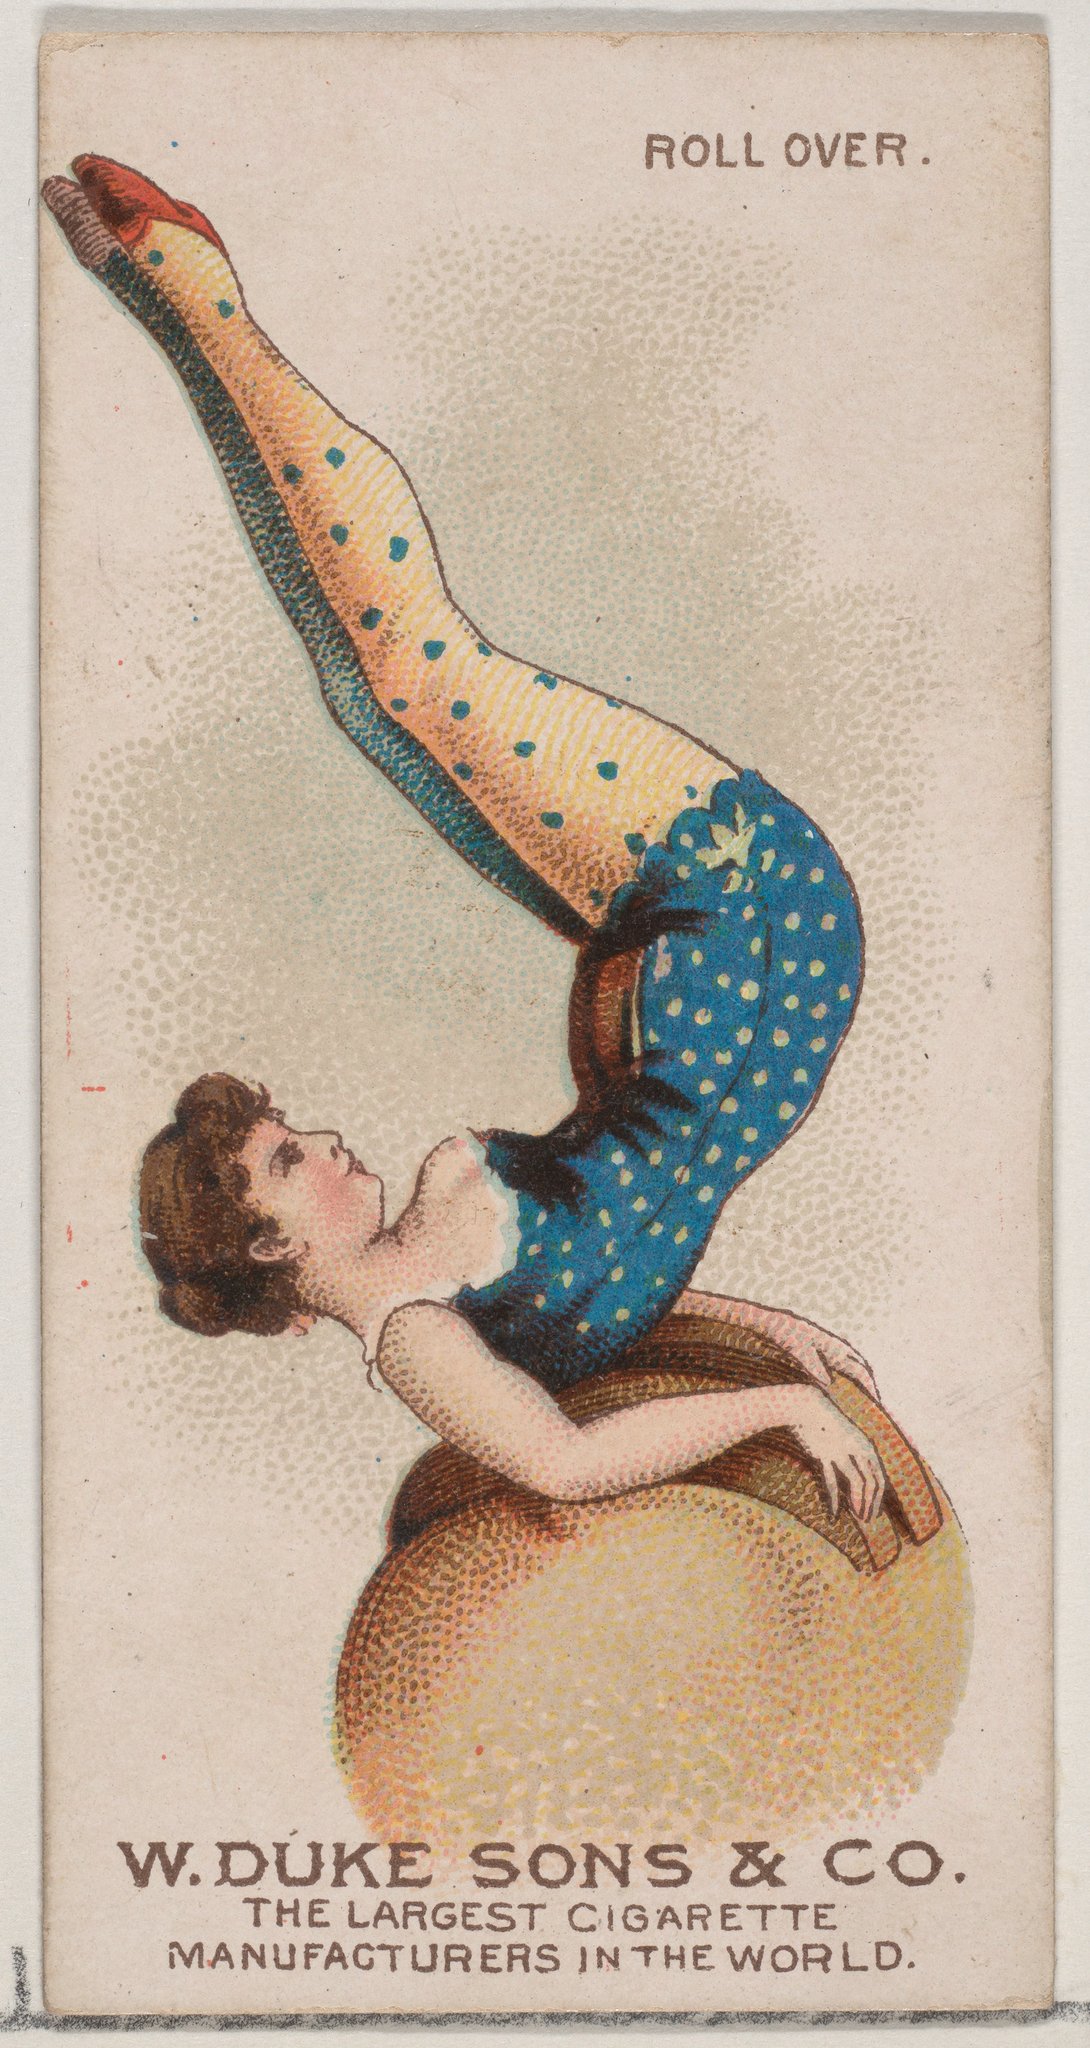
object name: print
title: Roll Over, from the Gymnastic Exercises series (N77) for Duke brand cigarettes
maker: w. duke, sons & co.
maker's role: publisher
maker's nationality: american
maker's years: 1870-1920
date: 1887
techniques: color lithograph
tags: women,sports,athletes